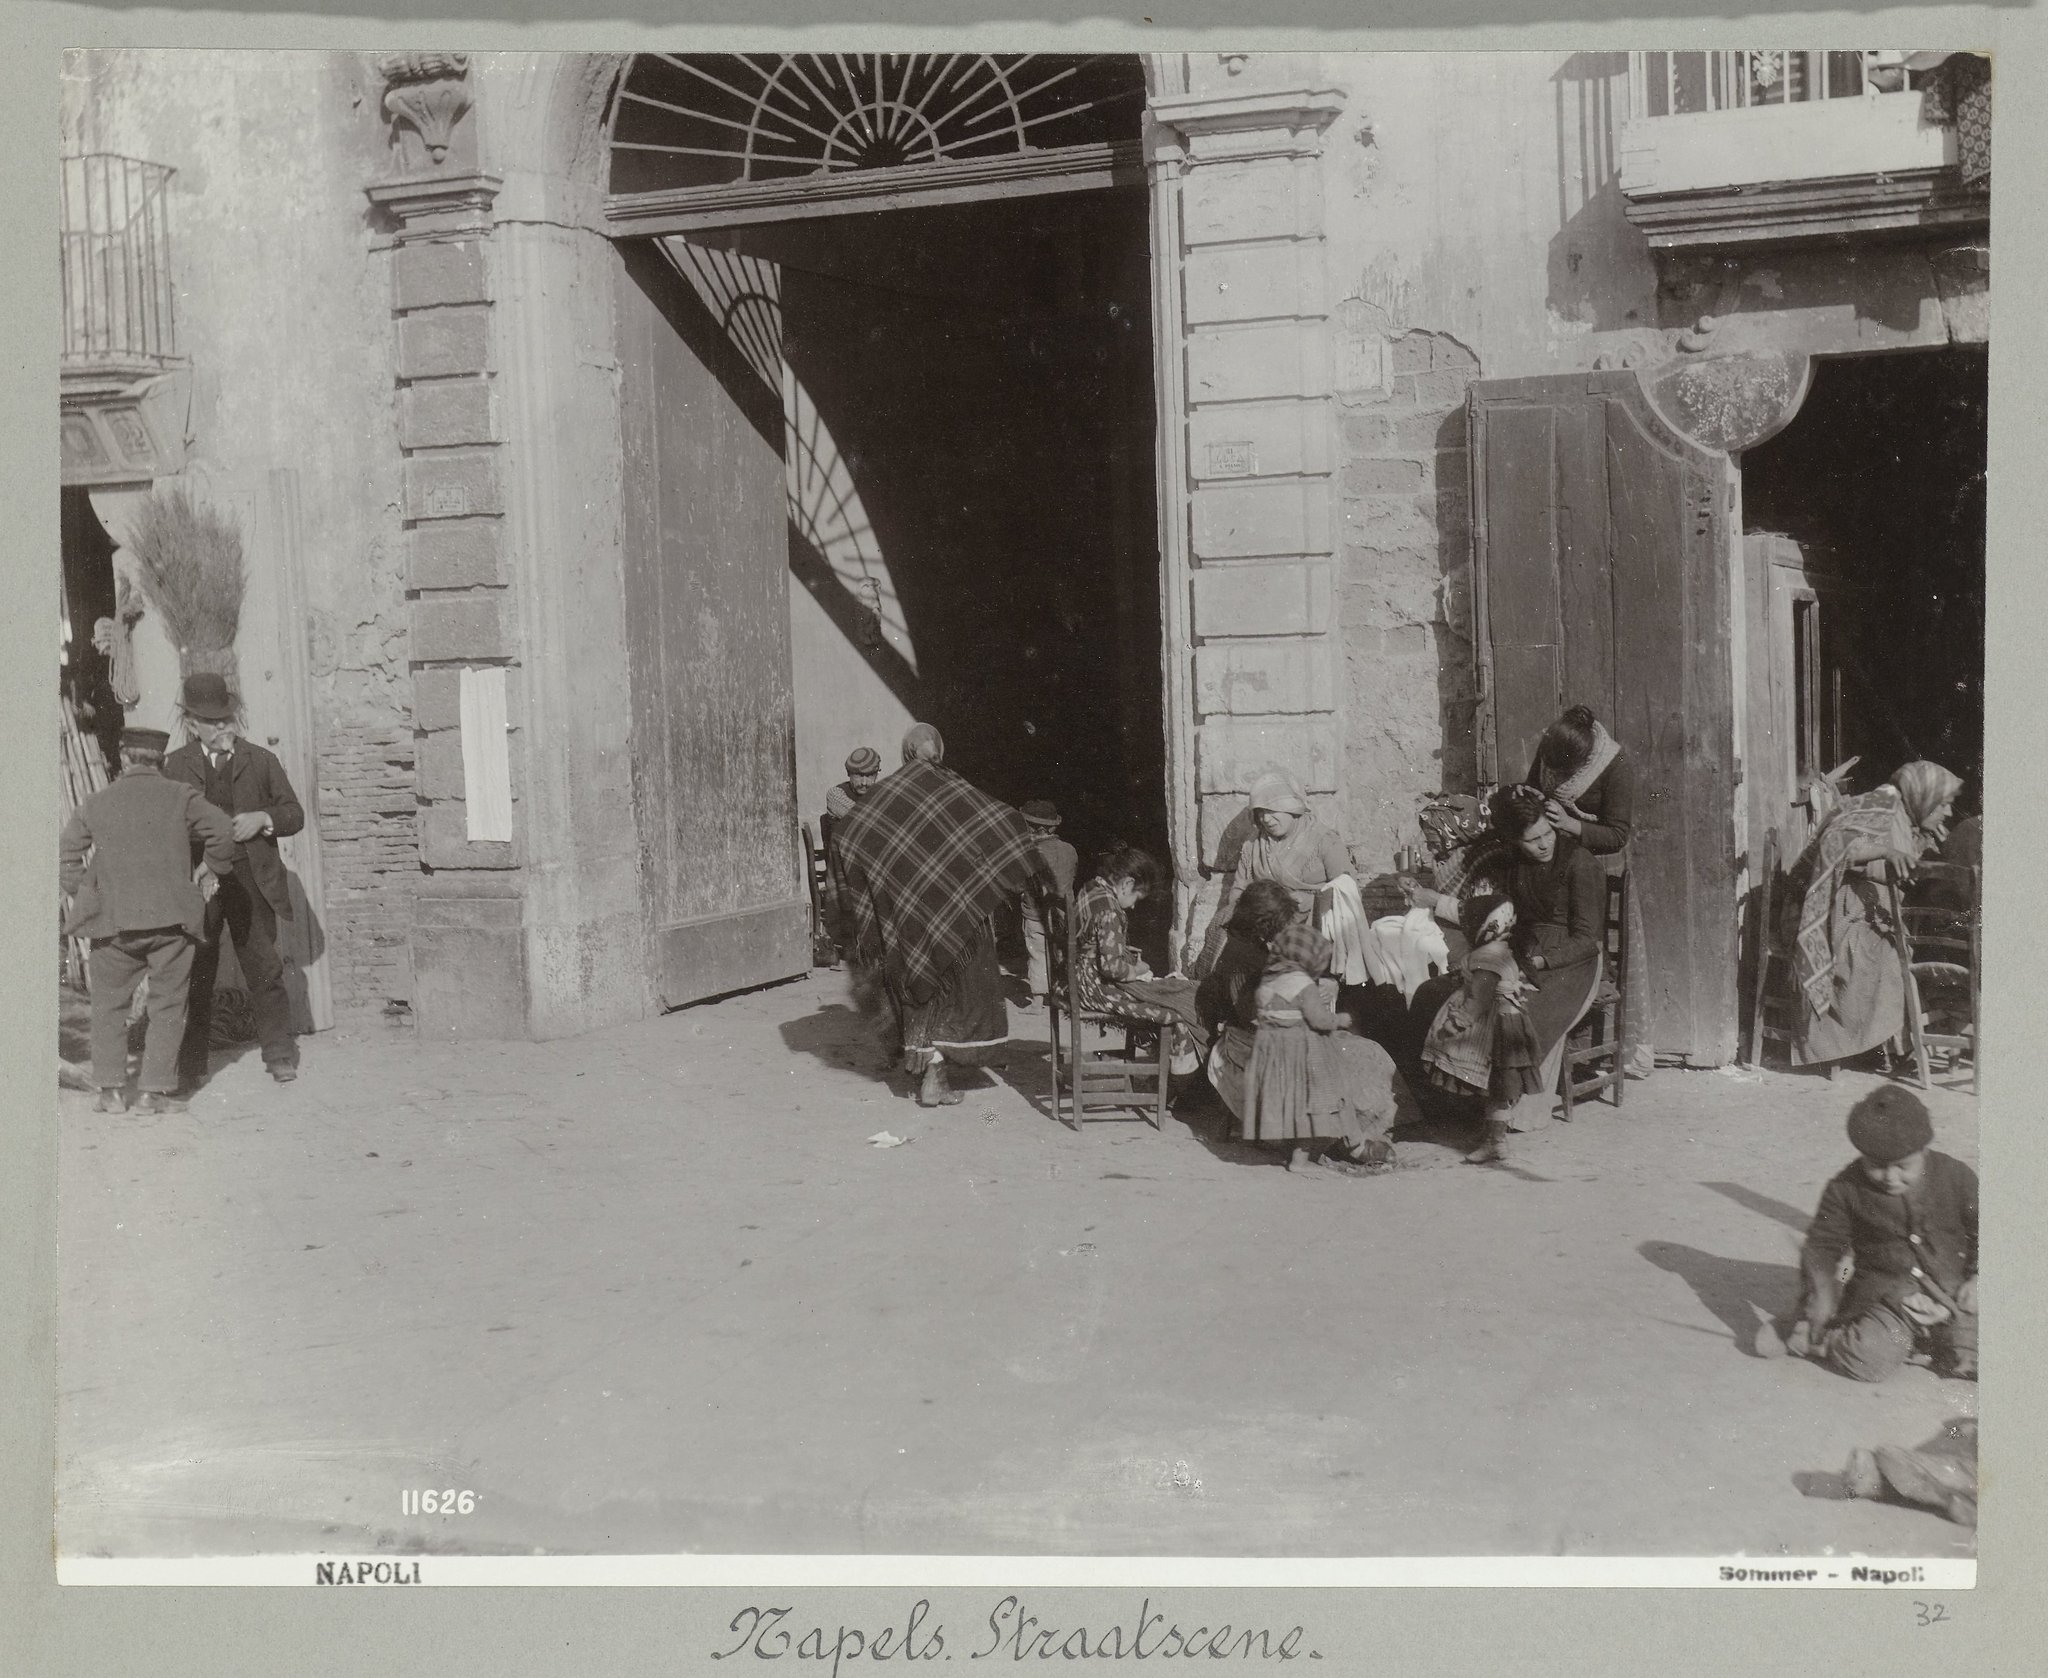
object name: photograph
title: Napels Straatscene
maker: giorgio sommer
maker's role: fotograaf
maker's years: 1834-1914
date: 1893-1903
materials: cardboard, photographic support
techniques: albumen print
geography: naples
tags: naples